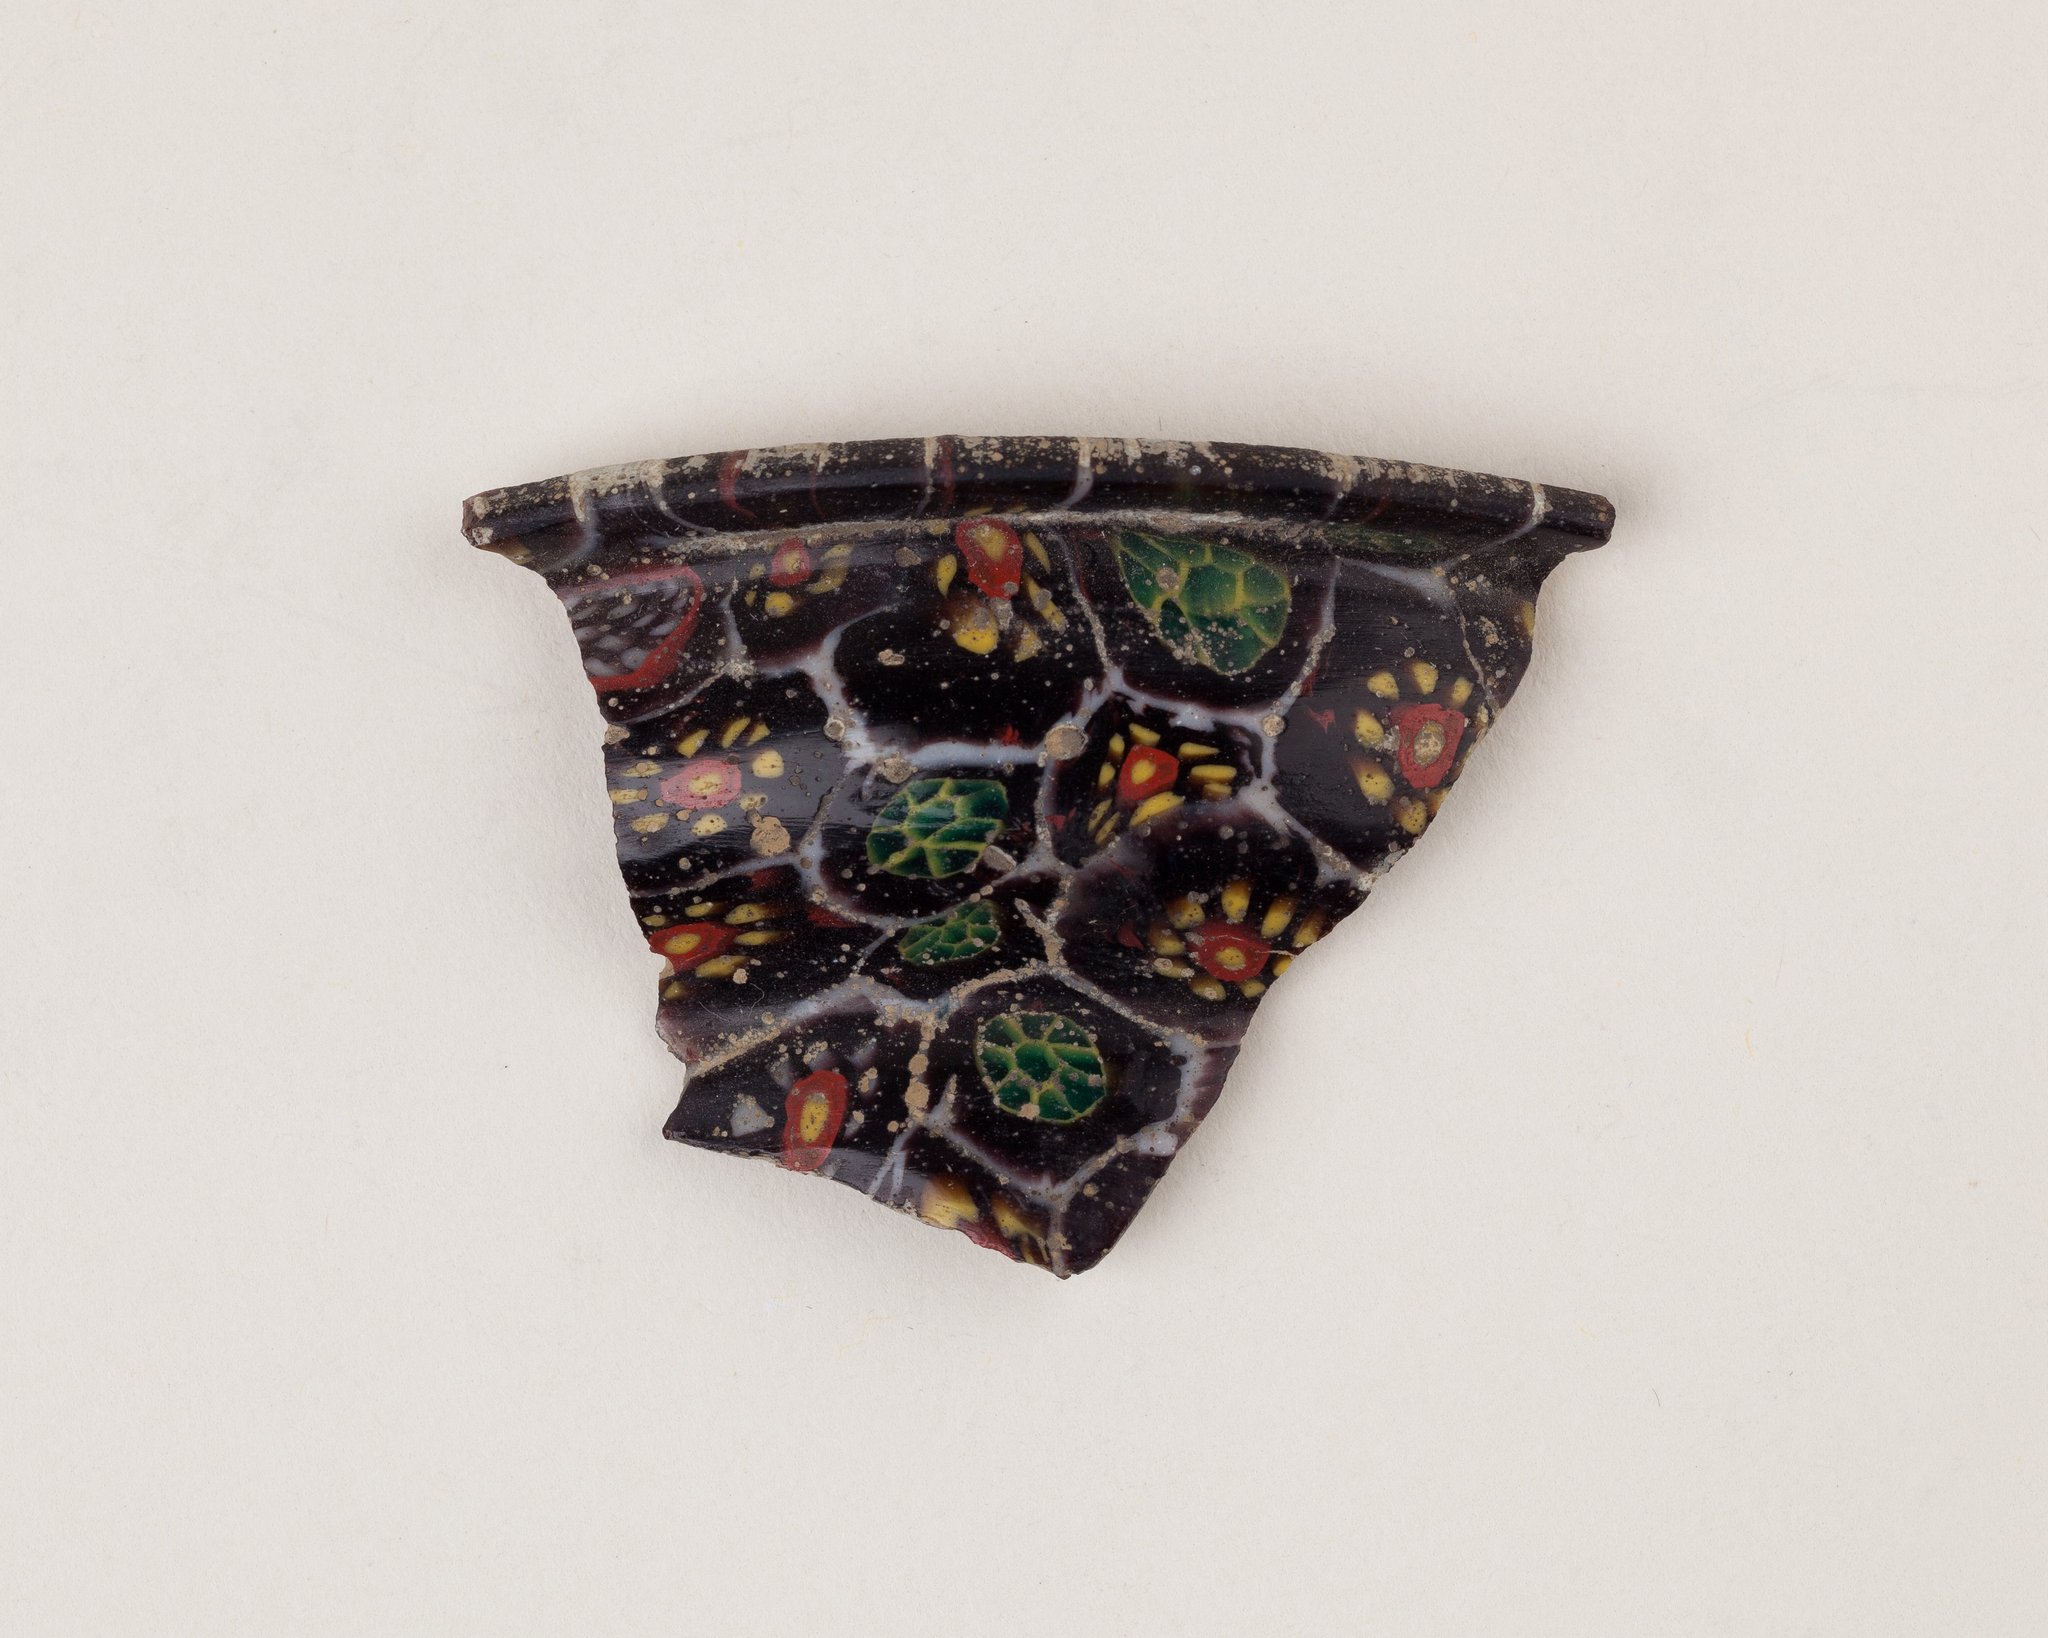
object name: vessel fragment, mosaic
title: Fragment of mosaic vessel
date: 100 BCE-100 CE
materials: glass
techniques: polychrome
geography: egypt